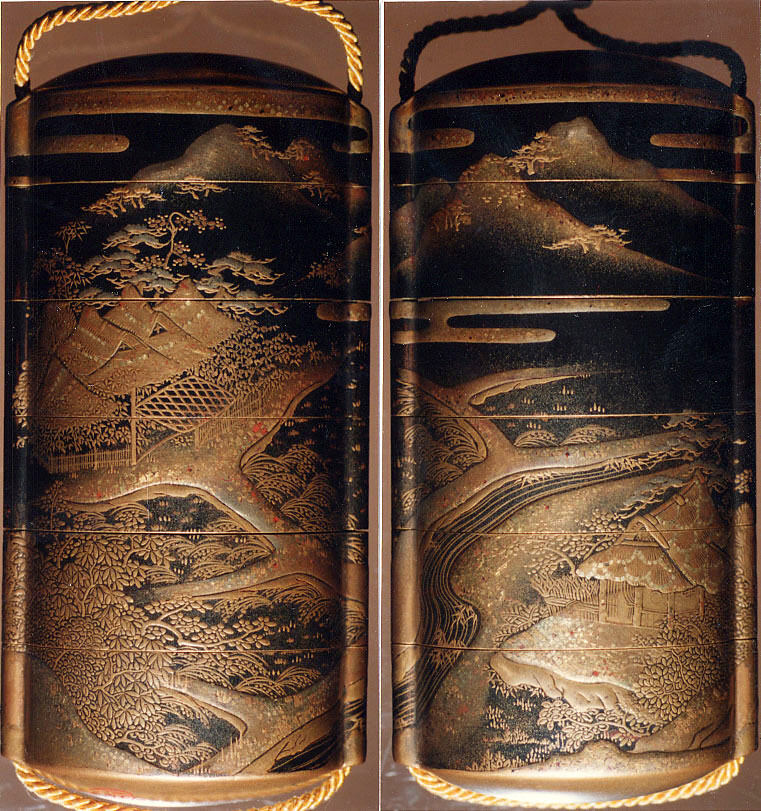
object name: inrō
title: Case (Inrō) with Design of Thatched Farm Buildings in Fields and Mountain Landscape with Cloud Bands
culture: japanese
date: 1801-1900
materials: gold, lacquer, silver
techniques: fundame, hiramakie, roiro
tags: buildings,landscapes